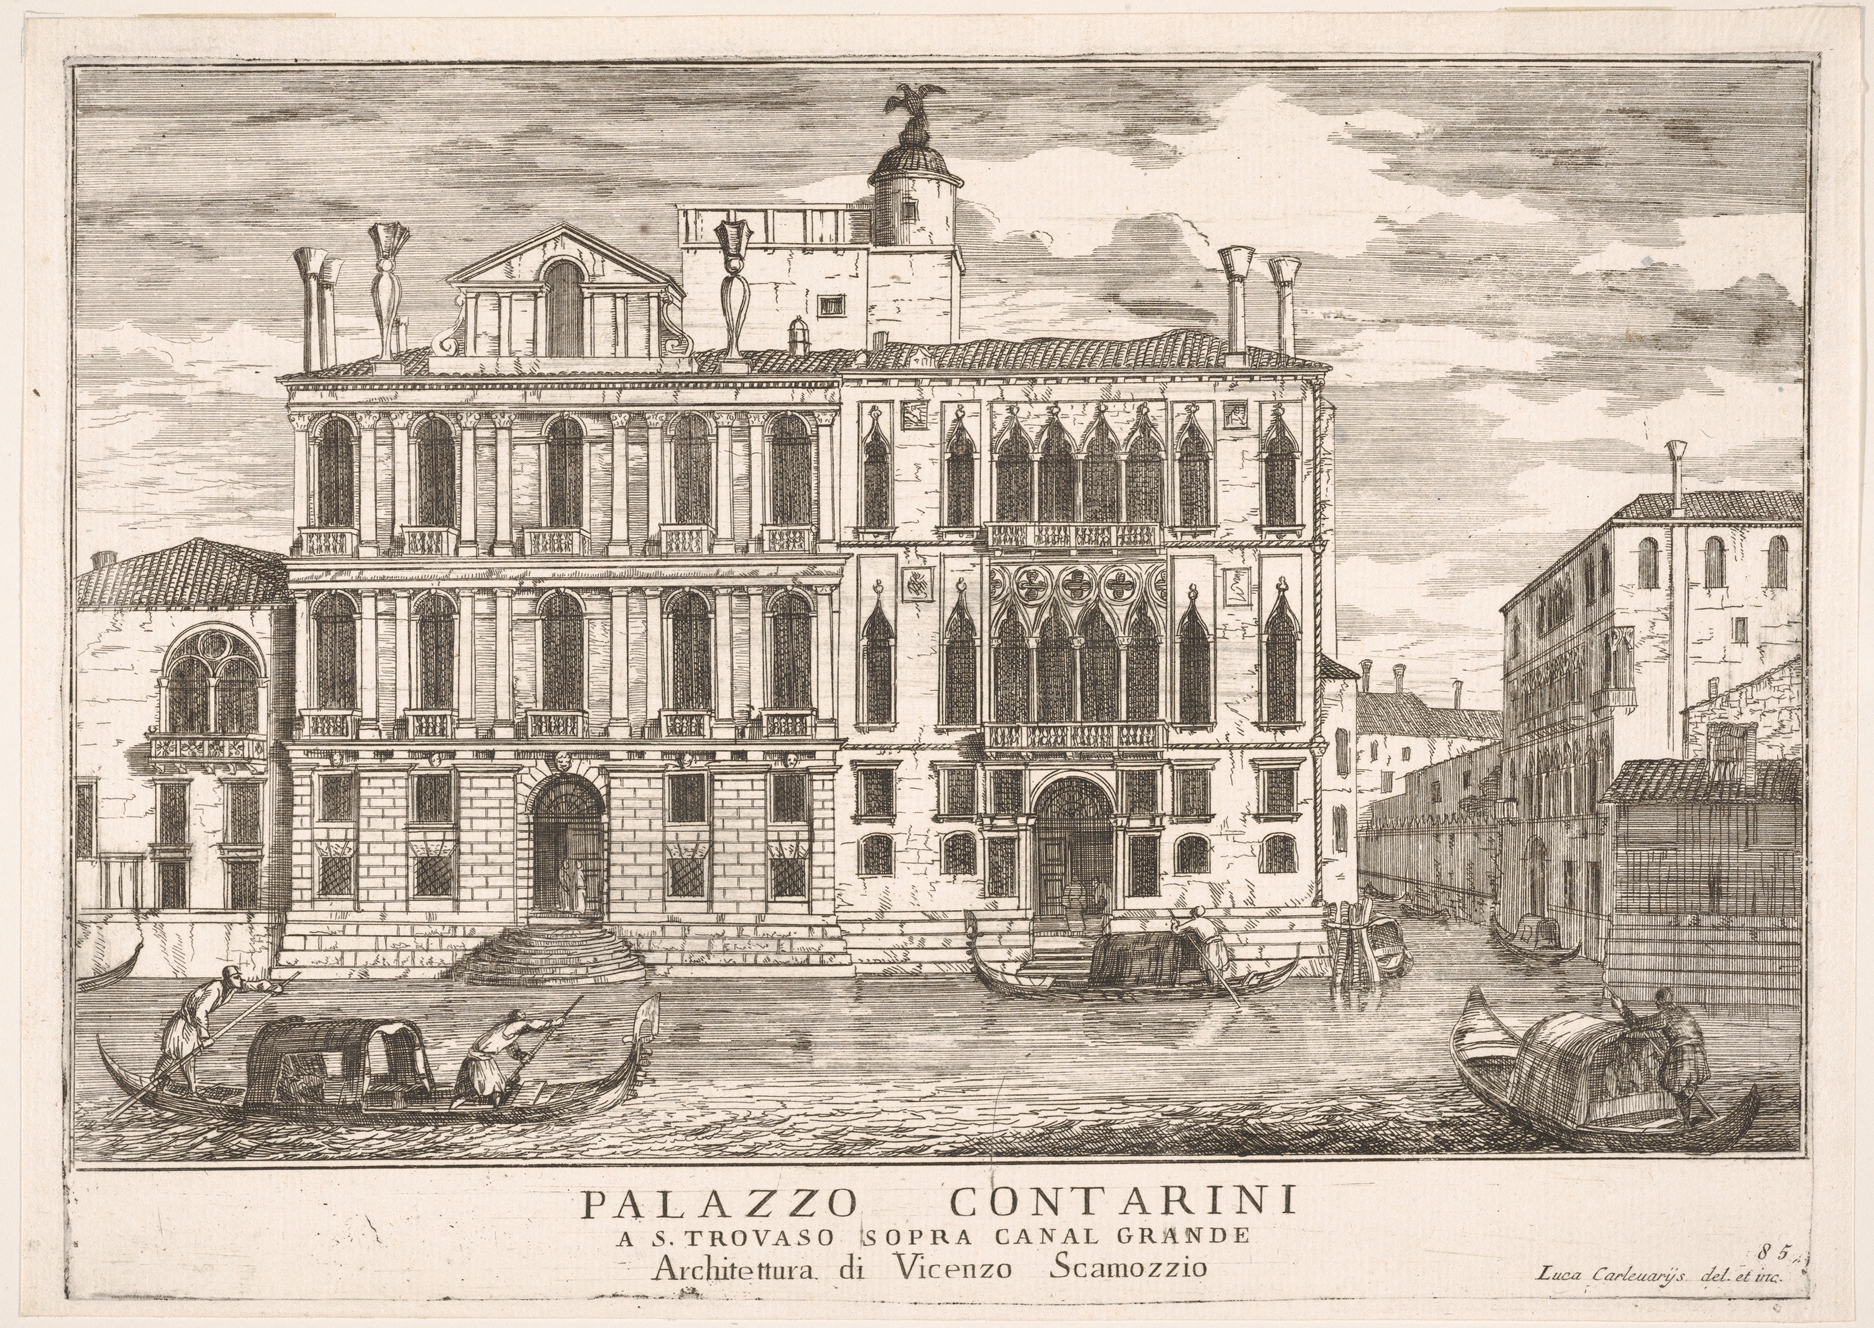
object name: print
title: Plate 85: View of the Contarini Palace in Campo San Trovaso, Venice, 1703, from "The buildings and views of Venice" (Le fabriche e vedute di Venezia)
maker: luca carlevaris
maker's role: artist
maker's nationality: italian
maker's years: 1663-1730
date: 1703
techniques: etching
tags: palaces,cities,boats,venice